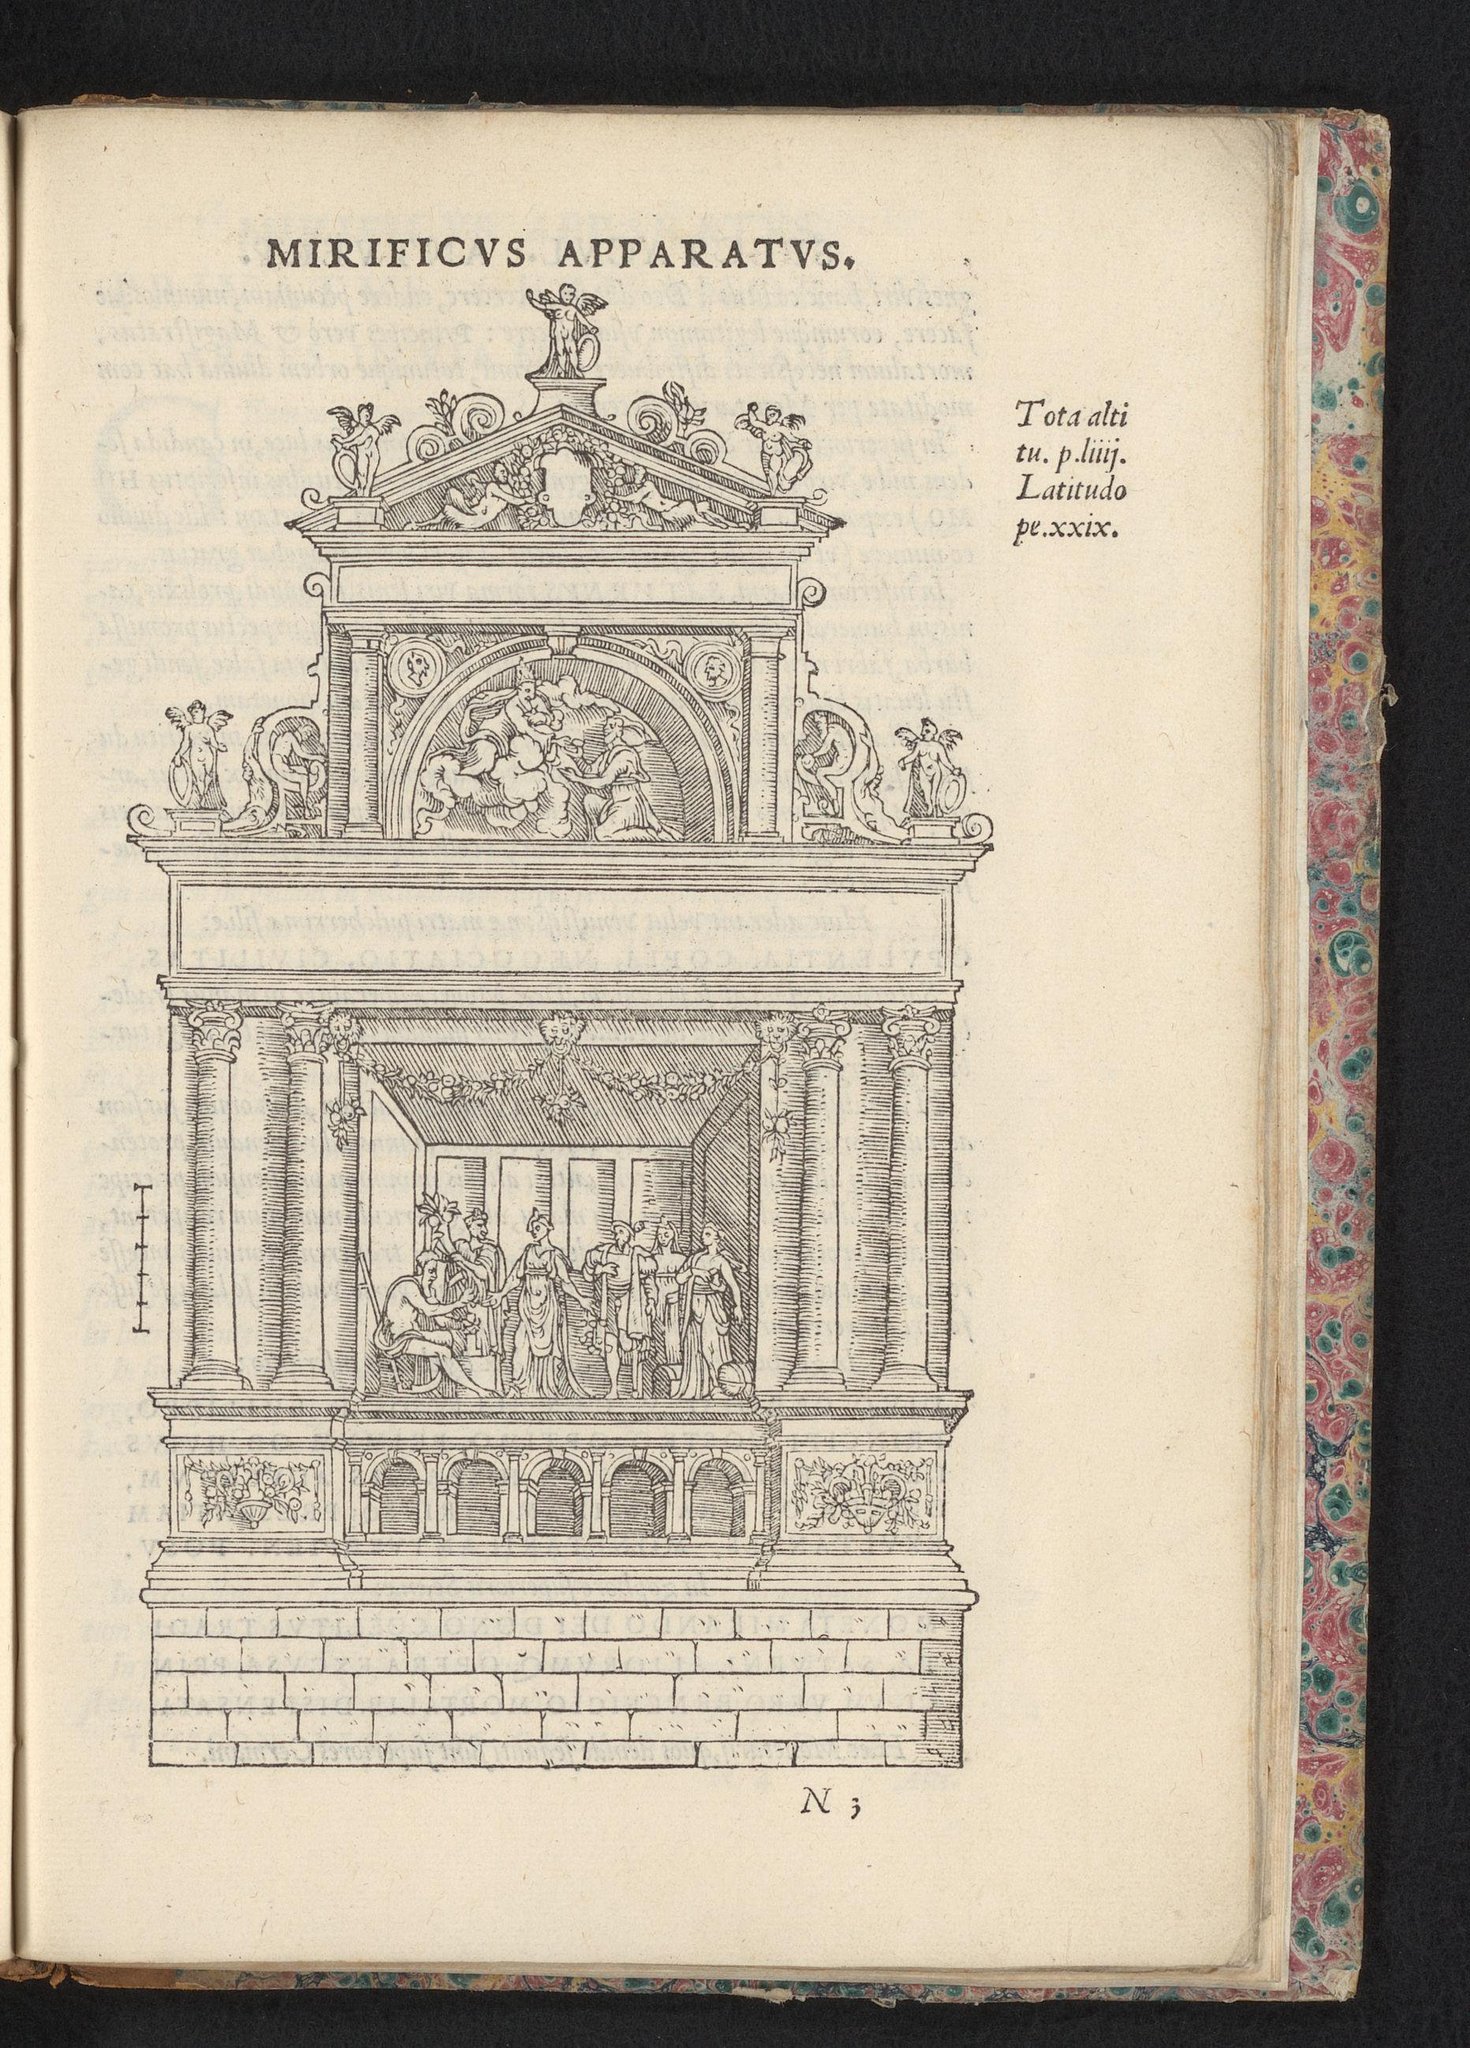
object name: print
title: Privatum monetariorum pegma, ad aedeis monetarias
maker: pieter coecke van aelst (i)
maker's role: draughtsman, print maker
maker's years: 1502-1550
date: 1549-1550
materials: paper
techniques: woodcut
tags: philip ii of spain, 'tableau vivant', triumphal arch, antwerp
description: Illustratie in: Spectaculorum in susceptione Philippi Hisp. Prin. Divi Caroli. V. Caes. F. ann 1549 Antverpiae aeditorum, mirificus apparatus. Tekst van Cornelius Grapheus, opgedragen aan Filips II, uitgegeven met keizerlijke privilege door Pieter Coecke van Aelst, gedrukt door Gillis van Diest. Boek in de bibliotheek met signatuur: 325 B 13.